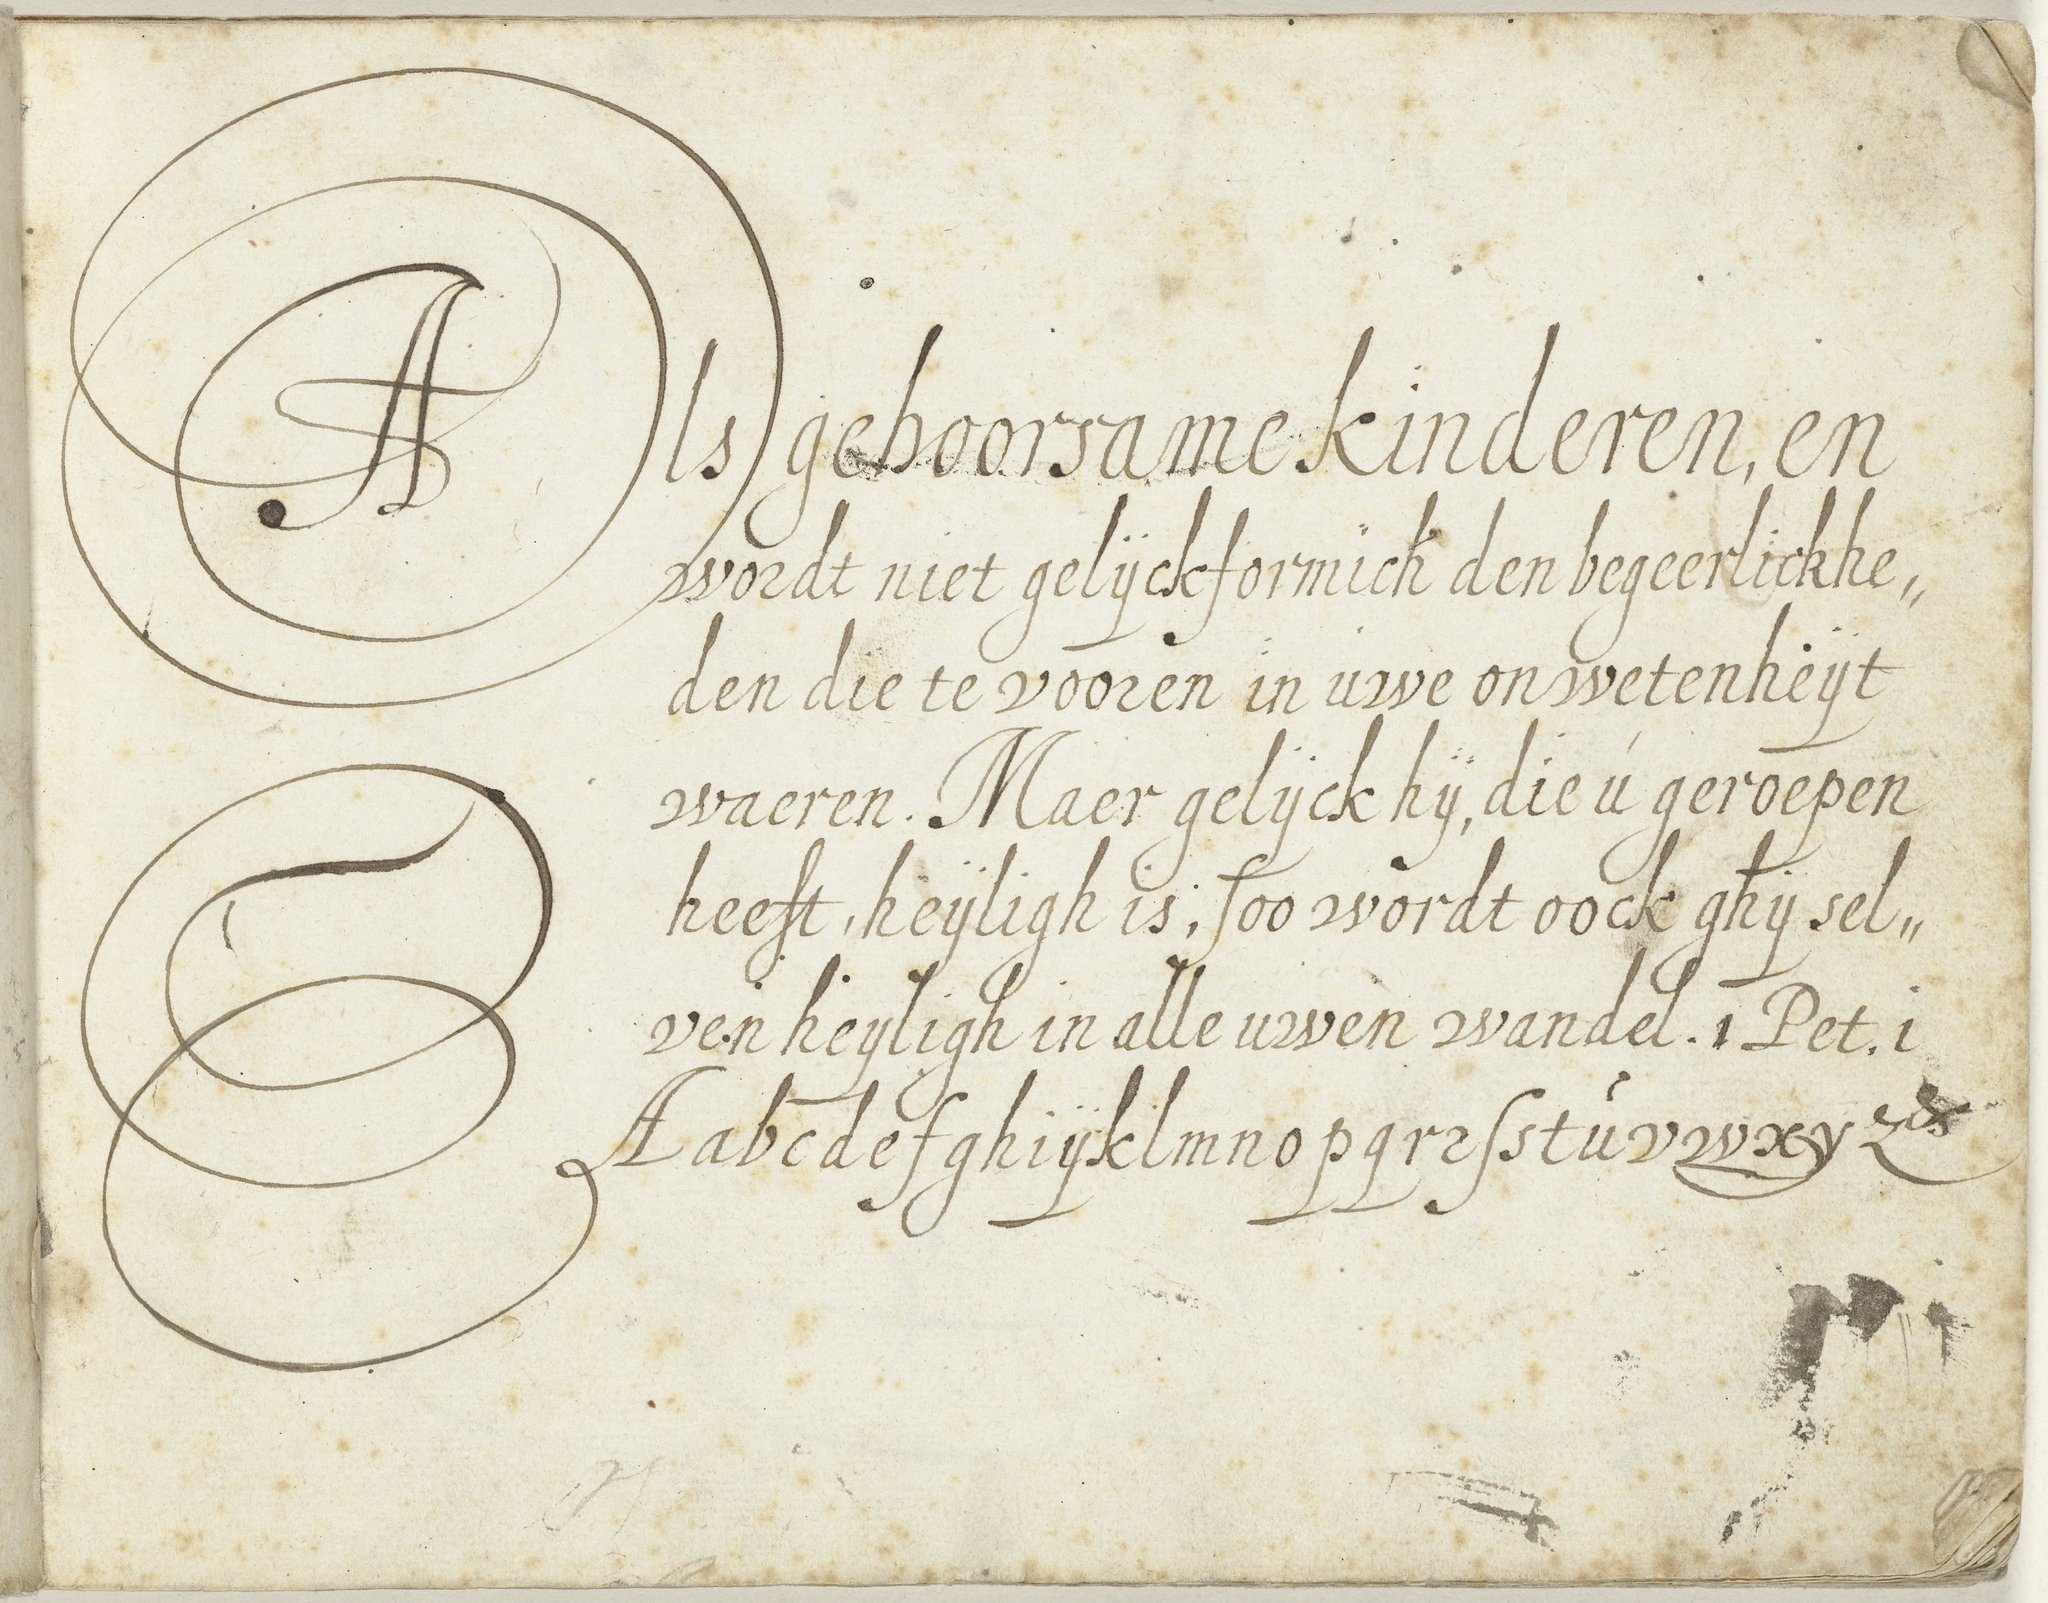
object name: calligraphy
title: Bijbelcitaat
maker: gesina ter borch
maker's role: draughtsman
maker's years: 1633-1690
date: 1646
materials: ink, paper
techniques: calligraphy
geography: zwolle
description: Bijbelse passage die Christenen aanspoort tot gelovig gedrag (Petrus 1:14-15, uit de Statenvertaling van 1637). Het eerste woord van de tekst begint met de letter A, wat gebruikelijk was bij Materi-Boecken. De teksten op de volgende twee pagina's beginnen achtereenvolgens met B en C.